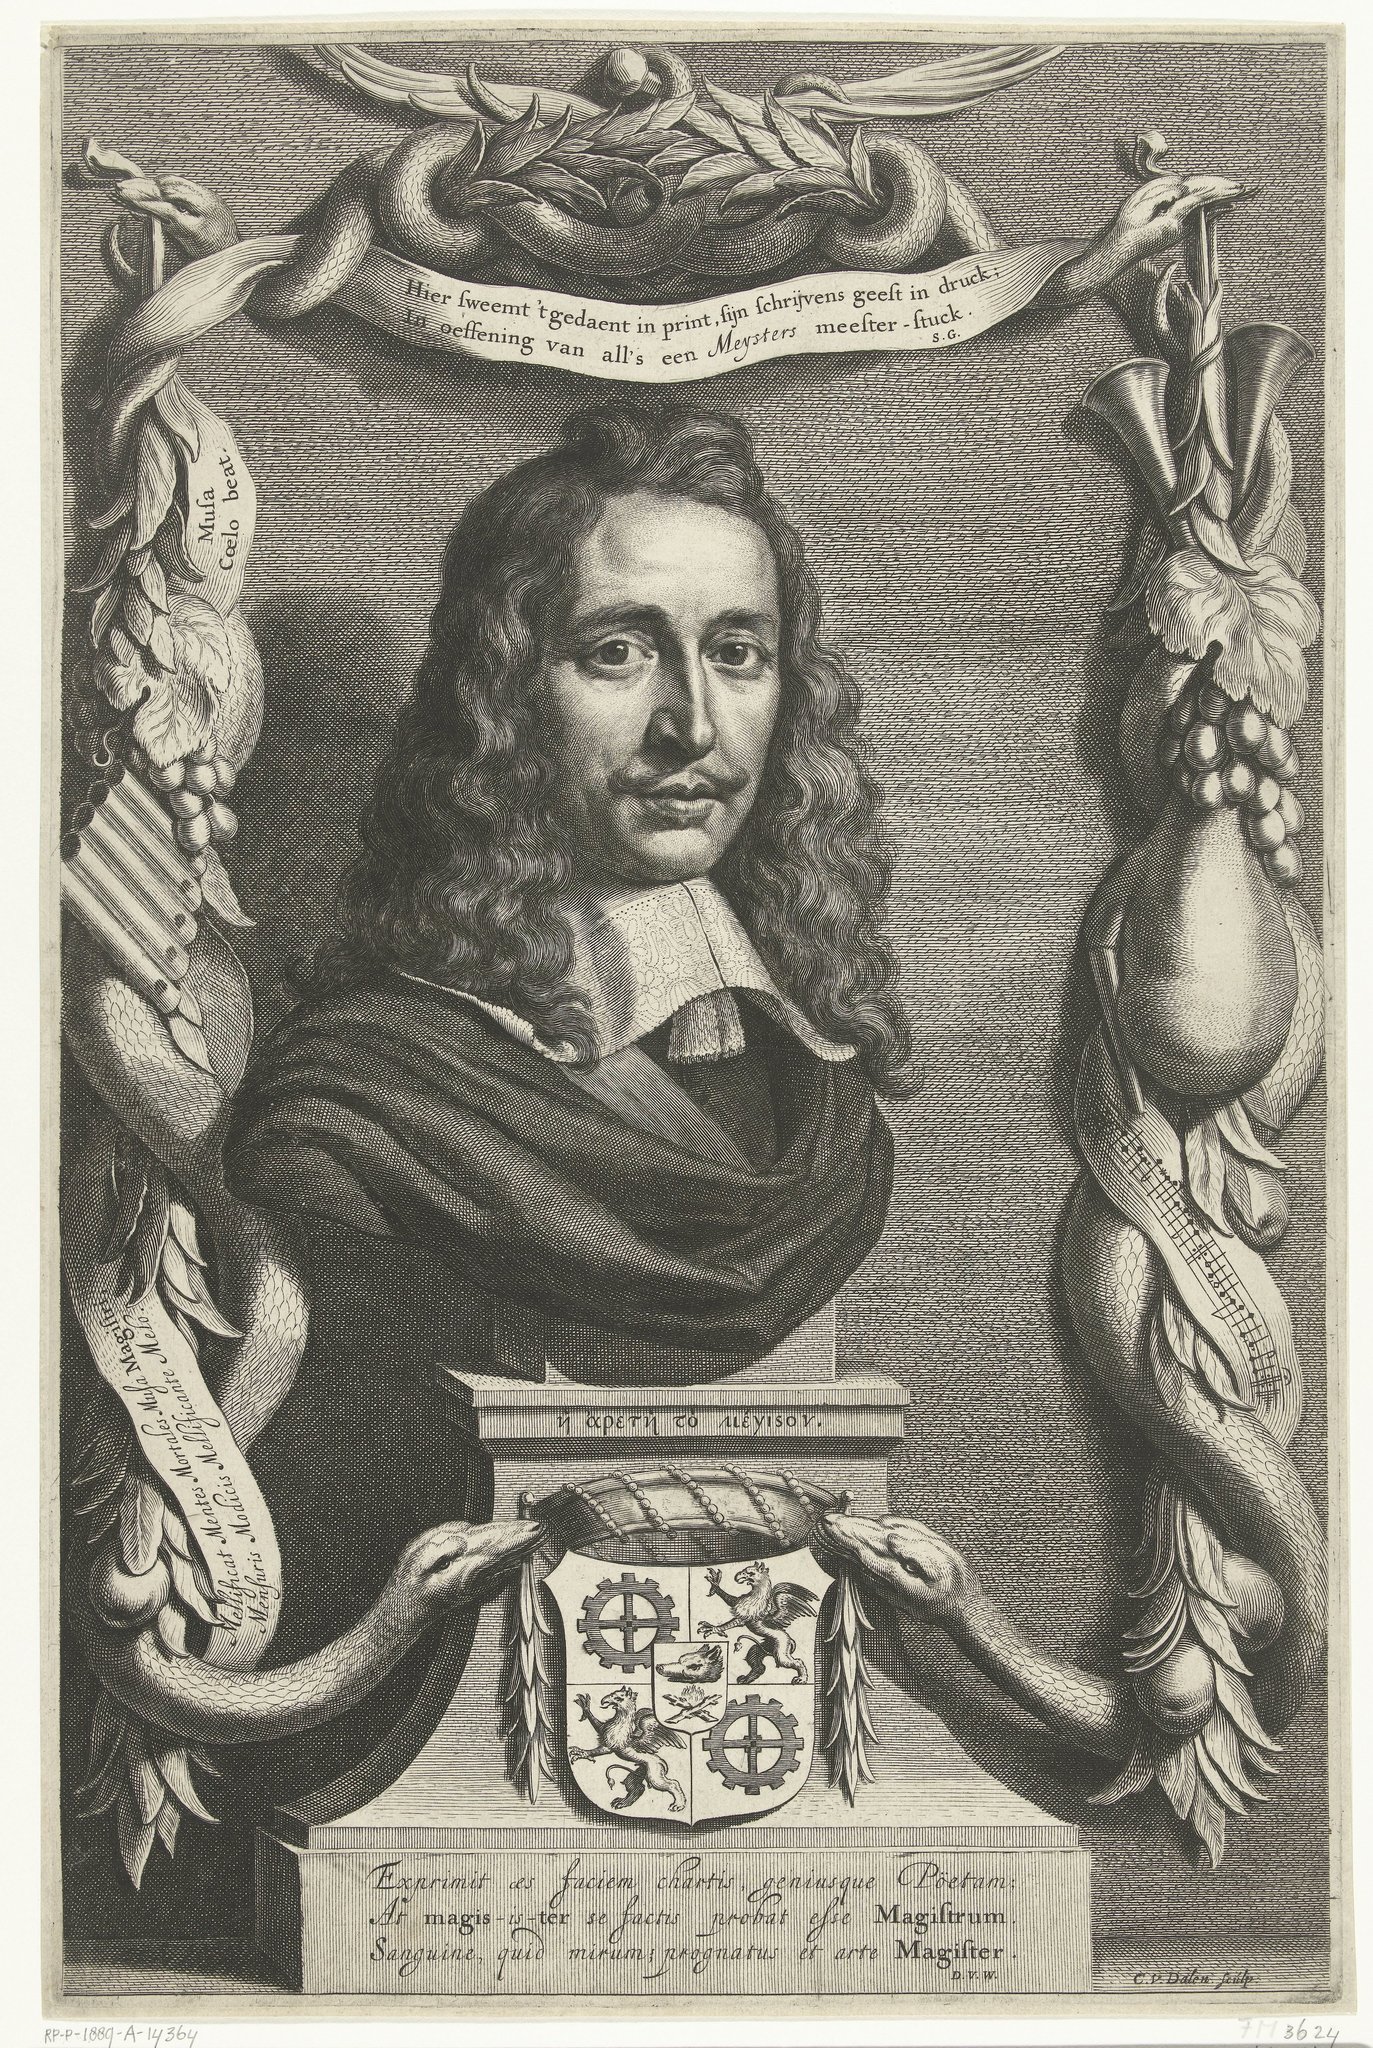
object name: print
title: Portret van jonkheer Everard Meyster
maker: cornelis van dalen (ii)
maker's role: draughtsman, print maker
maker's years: 1638-1664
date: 1648-1664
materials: paper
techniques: engraving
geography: amsterdam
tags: utrecht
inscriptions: collector's mark: Lugt 2228, collector's mark: Lugt 963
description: Portret van jonkheer Everard Meyster, buste op sokkel met zijn wapen. Binnen omlijsting van guirlandes samengesteld uit kronkelende slangen, lauwerkrans, muziekinstrumenten en fruit. In het vlechtwerk is een lint met Latijnse en Nederlandse verzen en een notenbalk opgenomen. Op de sokkel staat een Grieks opschrift.